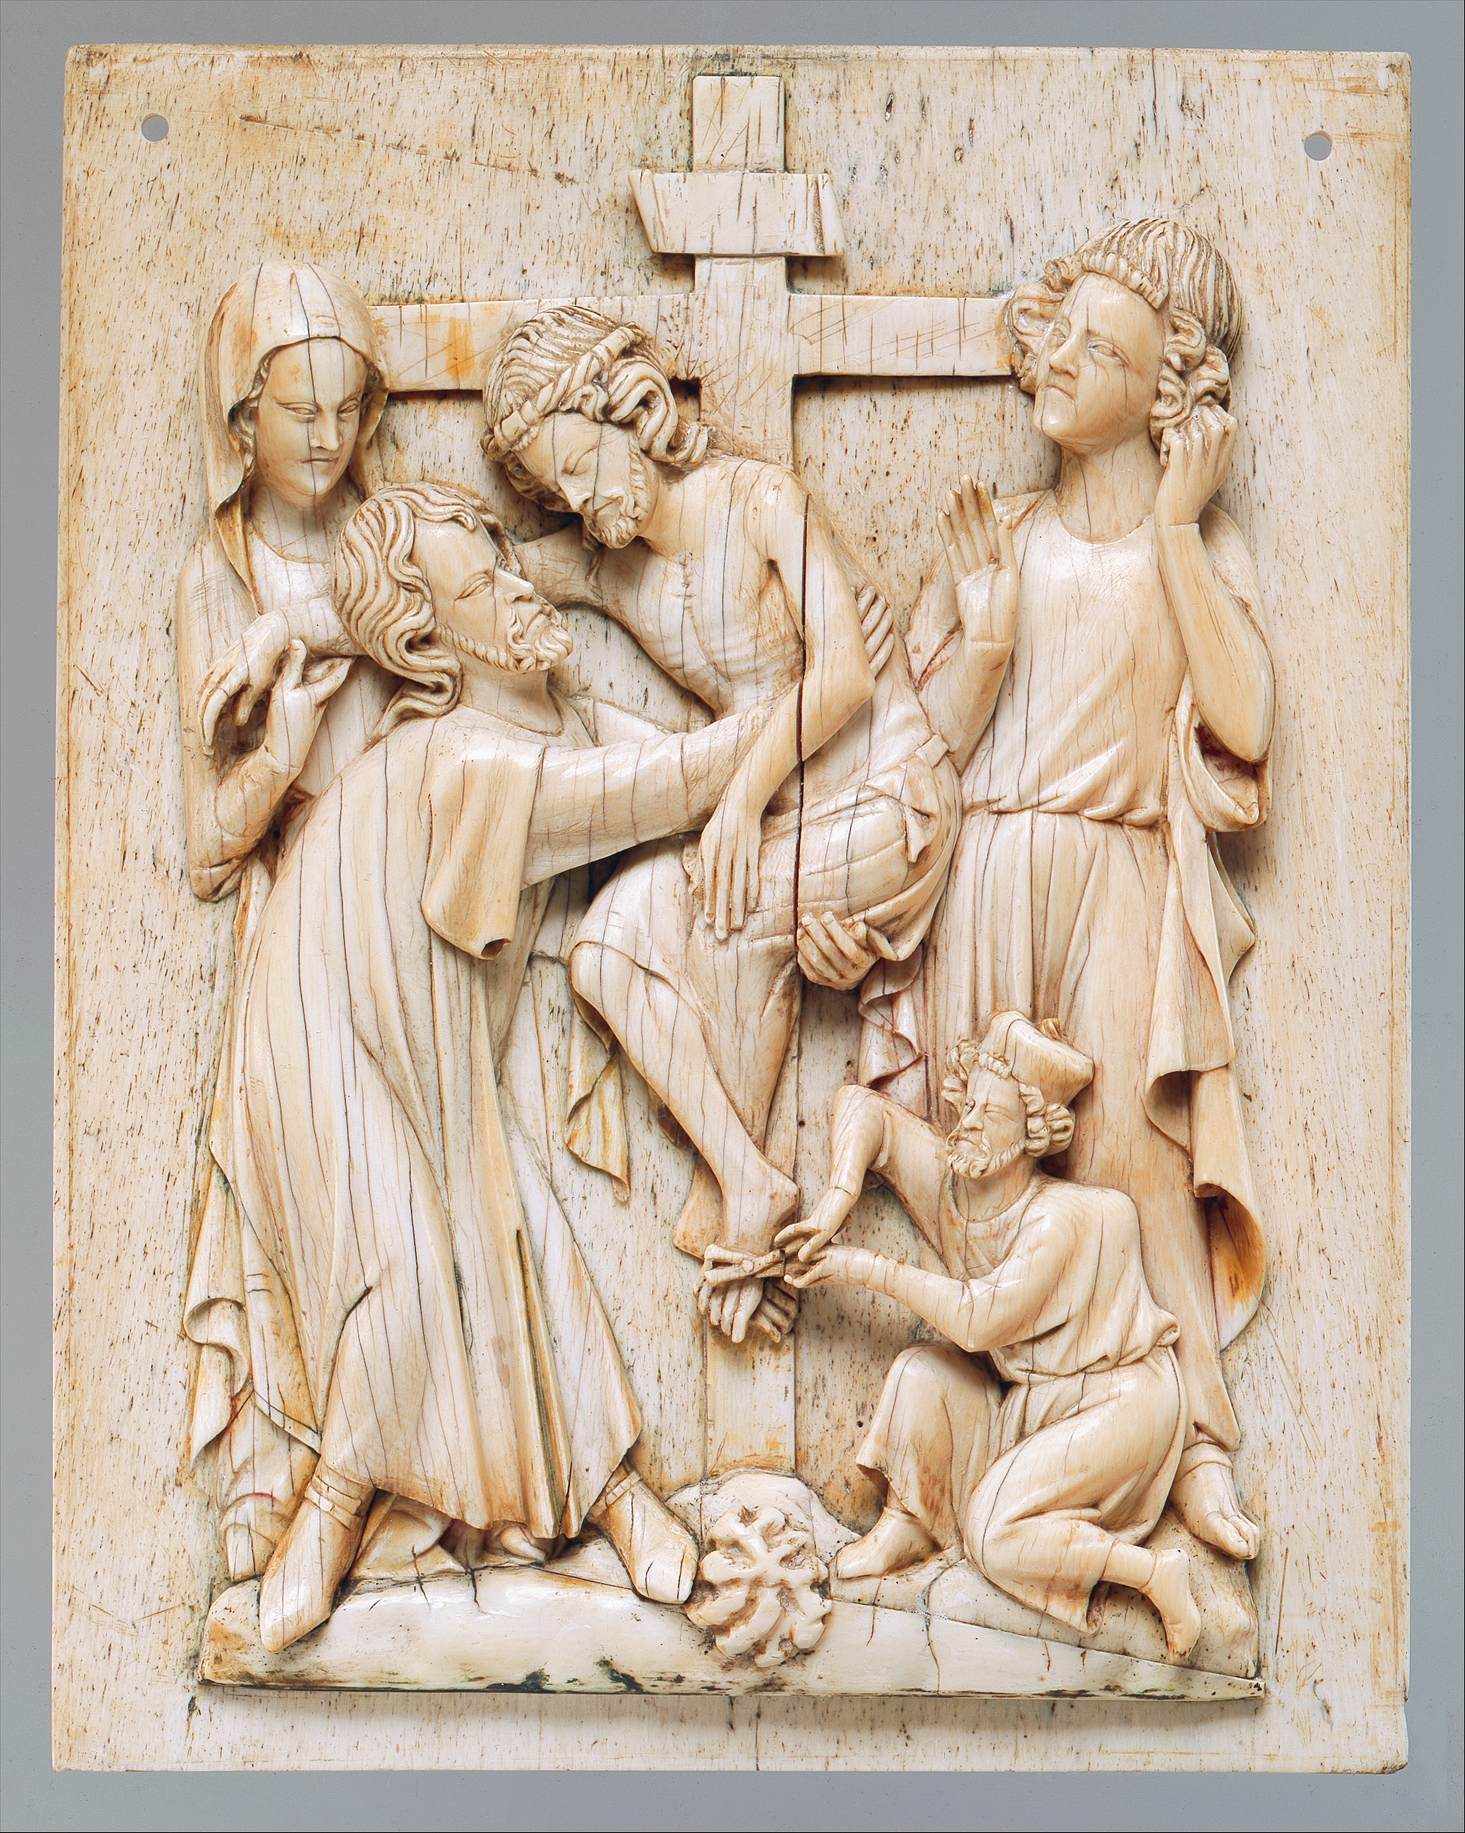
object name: plaque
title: Plaque with the Descent from the Cross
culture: french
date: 1320-1340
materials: bone, ivory, paint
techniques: gilding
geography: france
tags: christ,virgin mary,descent from the cross